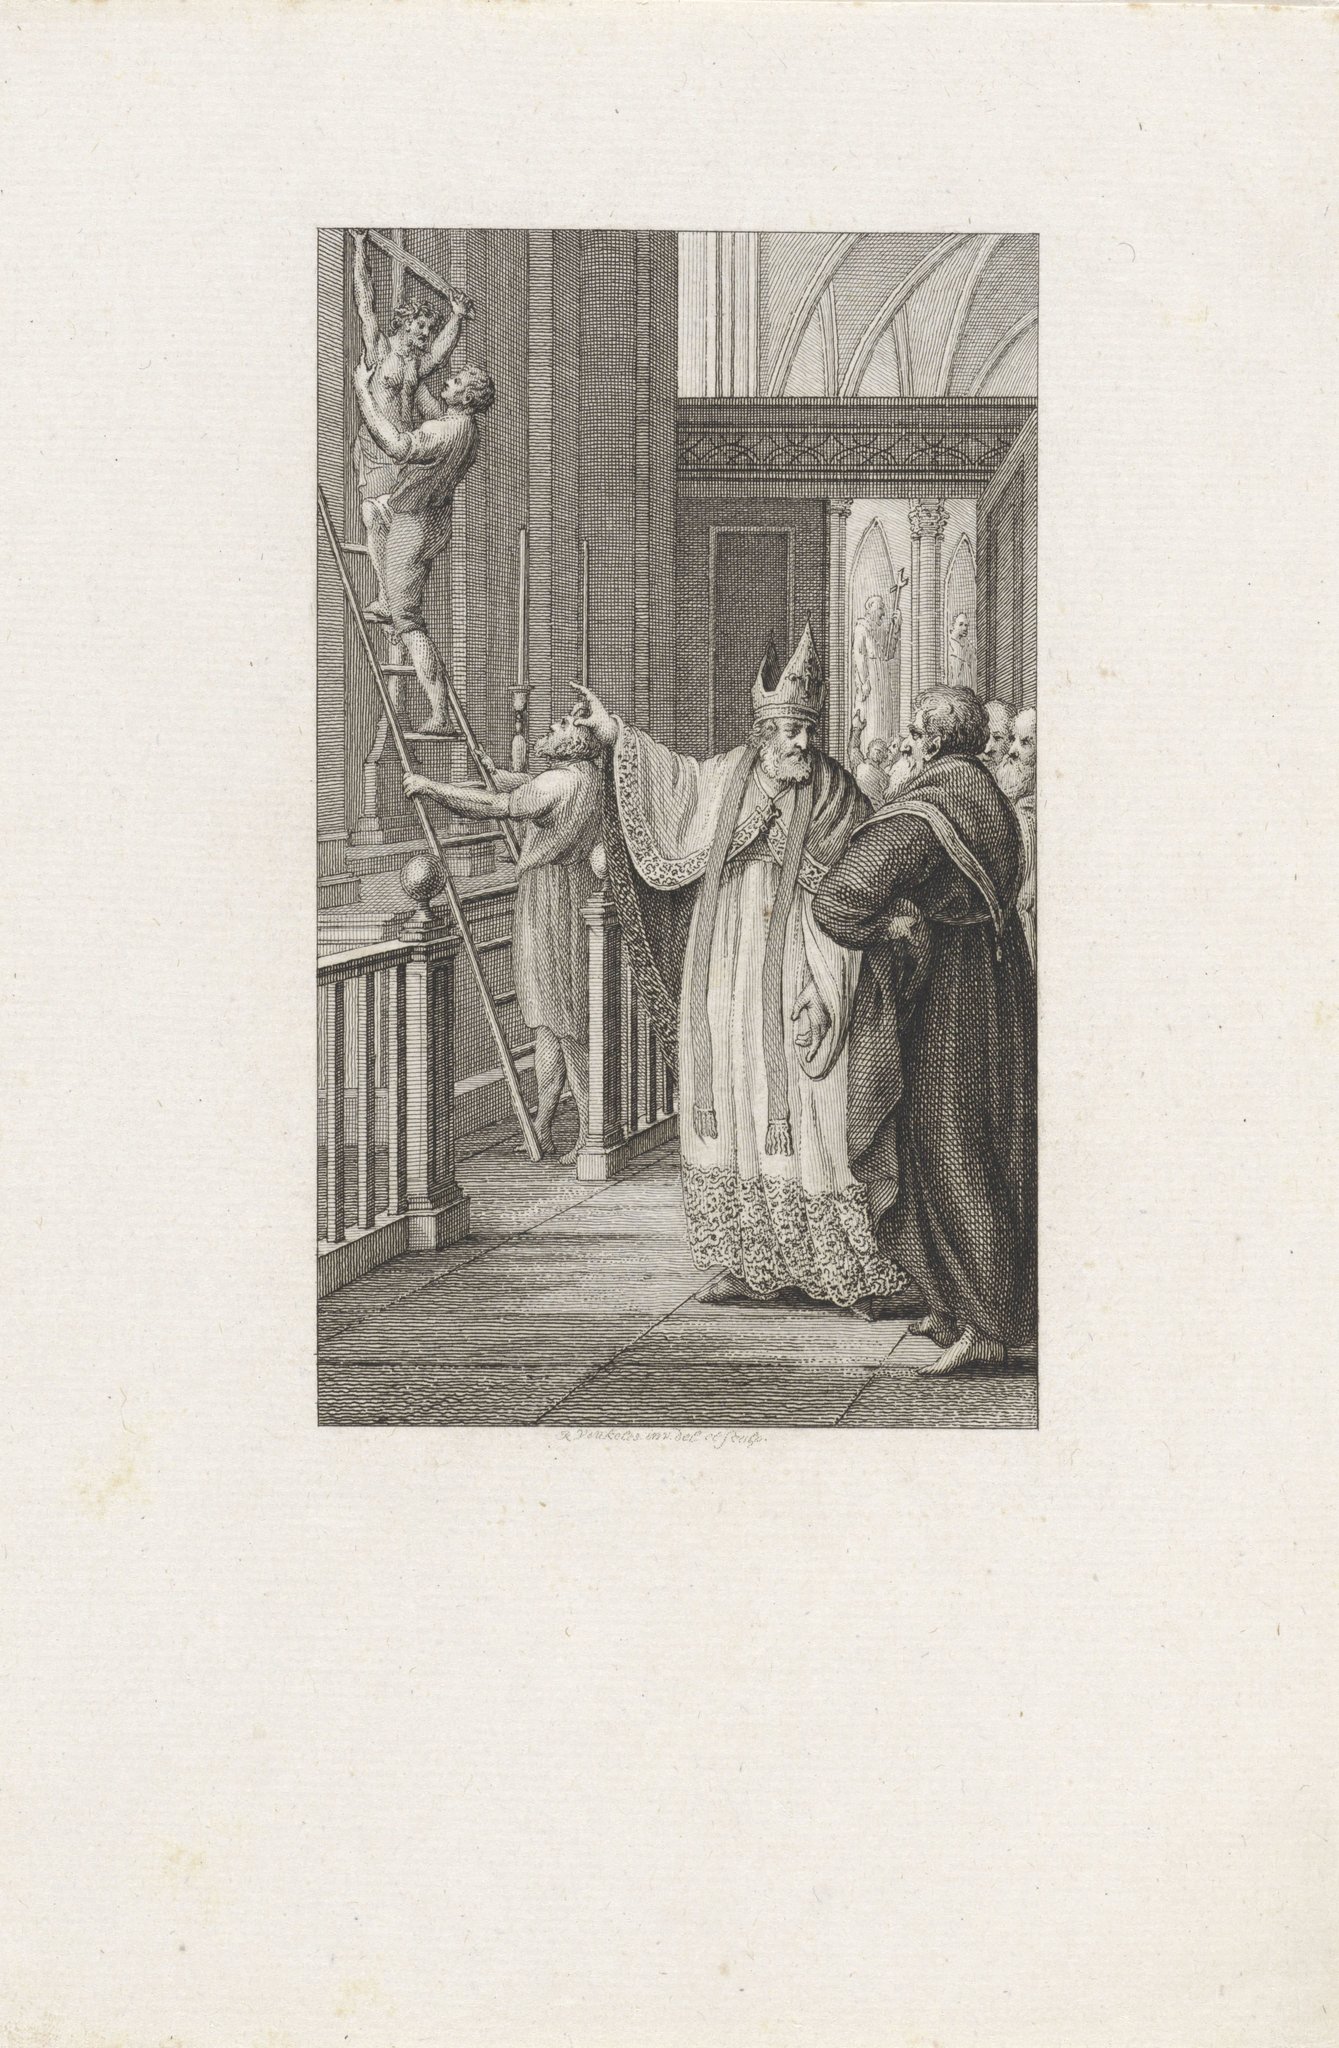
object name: print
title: Claudius bisschop van Turijn laat een kruisbeeld verwijderen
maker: reinier vinkeles (i)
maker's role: draughtsman, print maker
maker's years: 1741-1816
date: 1807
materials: paper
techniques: engraving, etching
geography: amsterdam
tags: altarcross, crucifix, cardinal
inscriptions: collector's mark: Lugt 2228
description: Proefdruk van illustratie in: Hamelsveld, Ysbrand van. Algemeene kerkelijke geschiedenis, der Christenen, deel 14. Haarlem: François Bohn, 1807, p. 191.